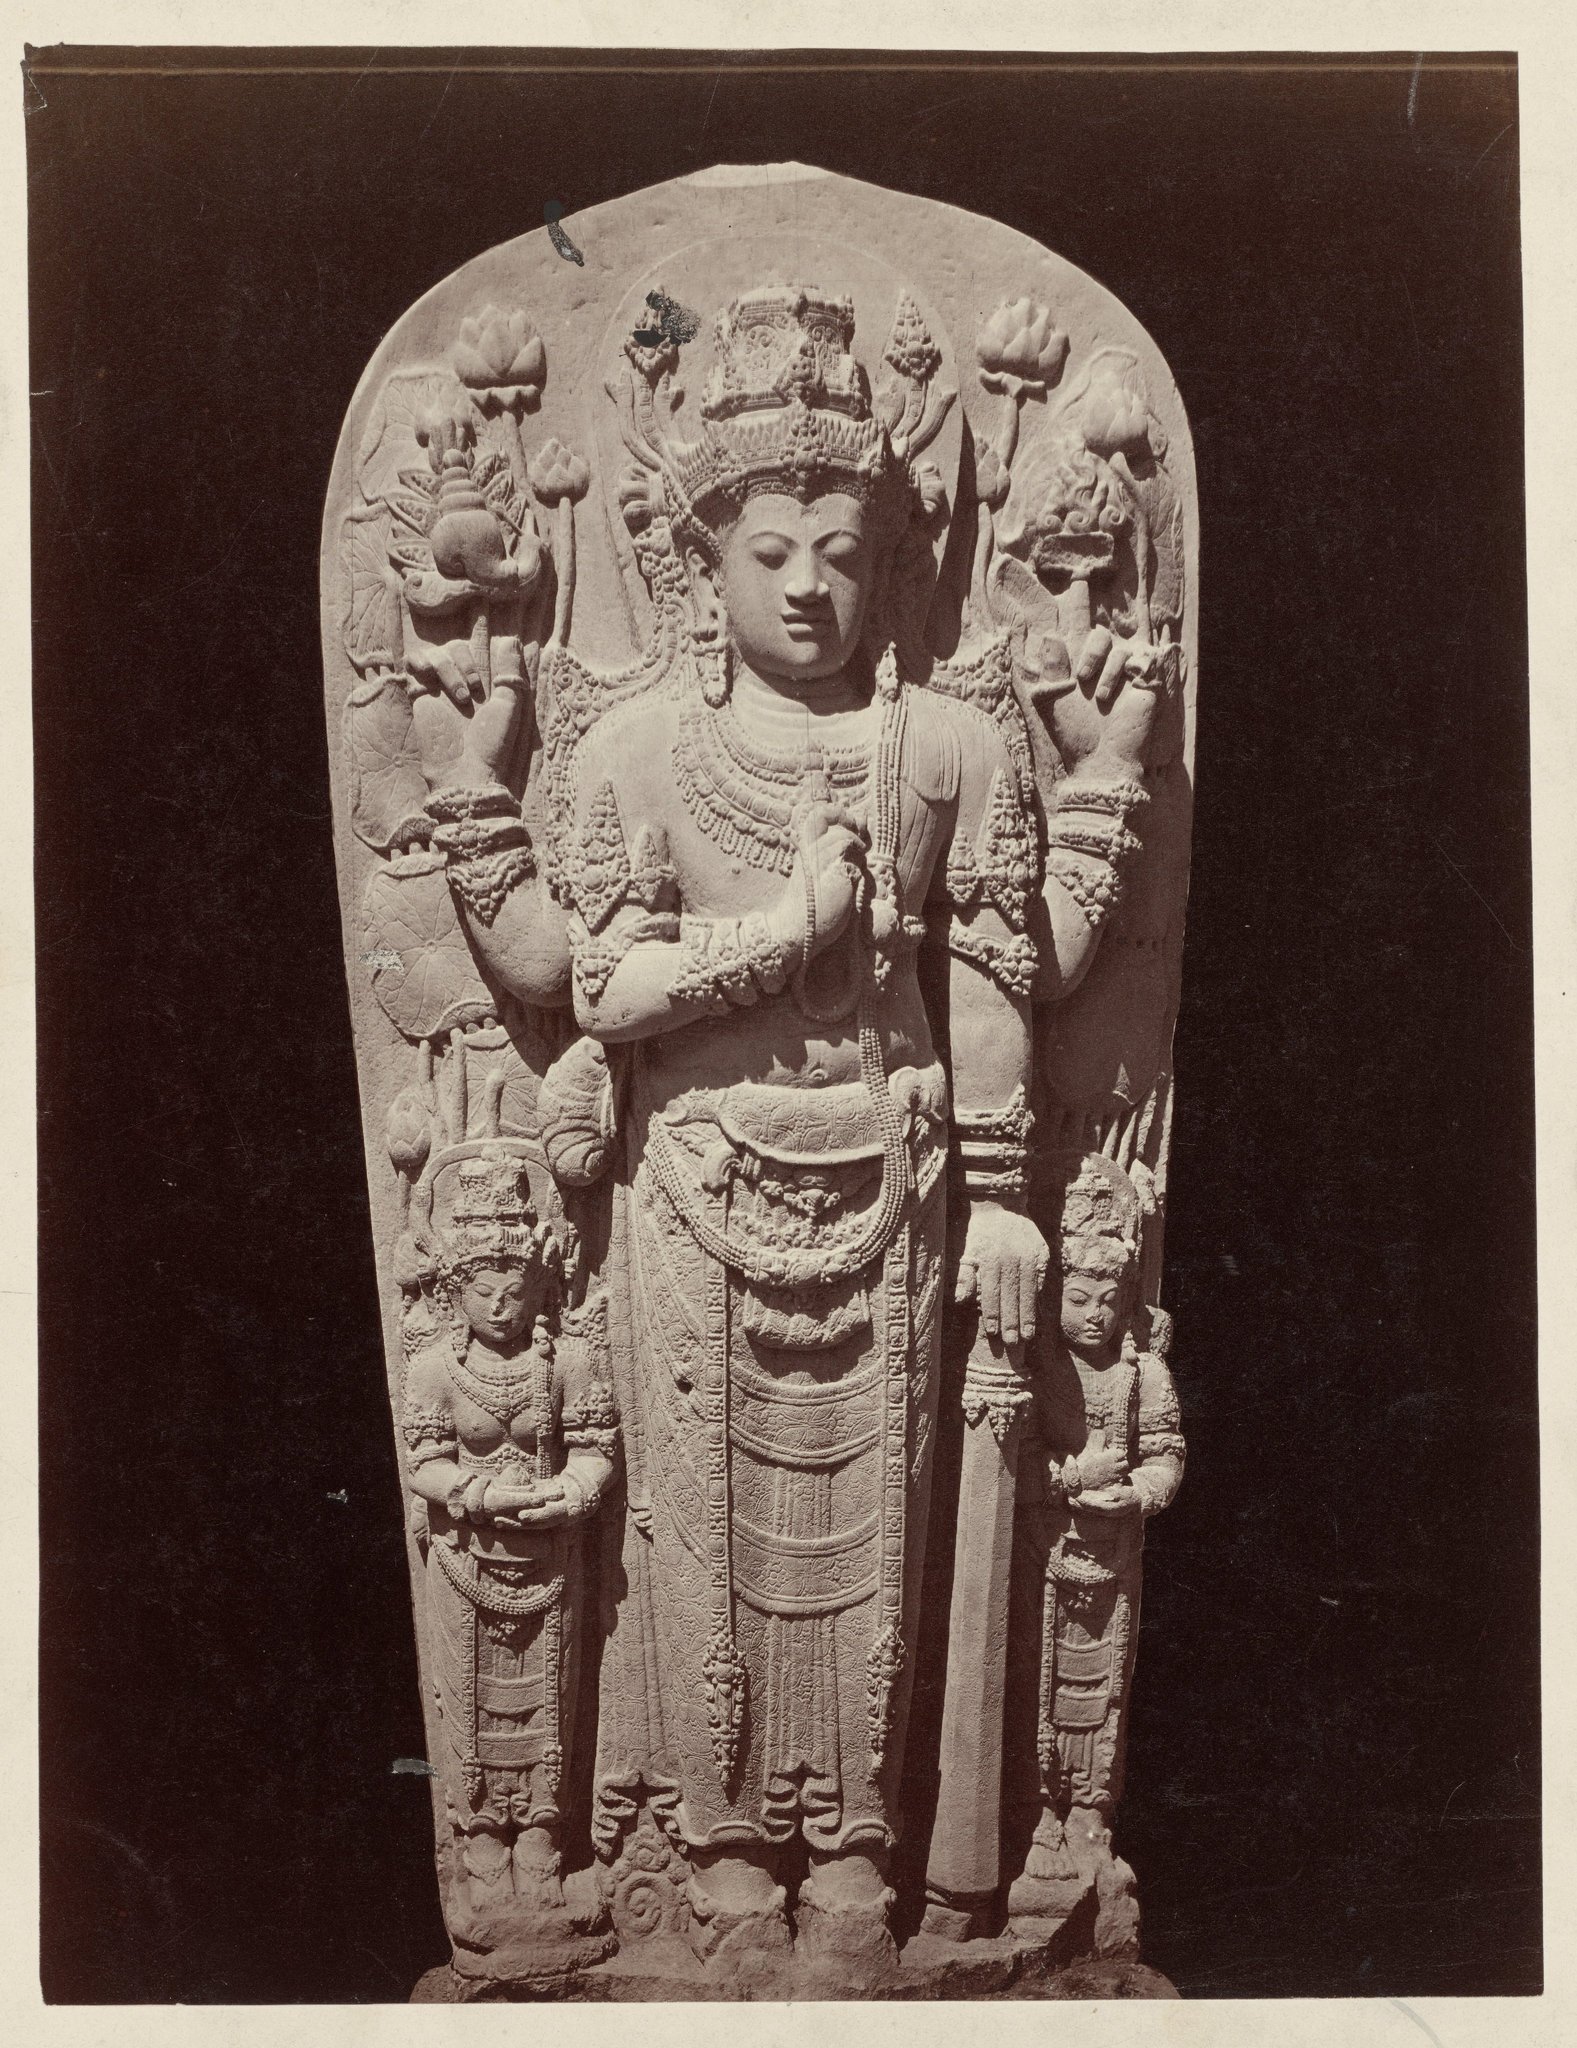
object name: photograph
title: Four-armed deification stele (King Kritarajasa?) from Sumberjati showing features of both Vishnu and Shiva. Blitar, Blitar district, East Java province, 14th century, Indonesia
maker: isidore kinsbergen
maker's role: fotograaf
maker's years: 1821-1905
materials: cardboard, paper, photographic support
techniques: albumen print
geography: java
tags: shiva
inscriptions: title: ‘Vishnoe op de Hoofdplaats (Blitar) (Residentie Kediri) Cat. no. 238’